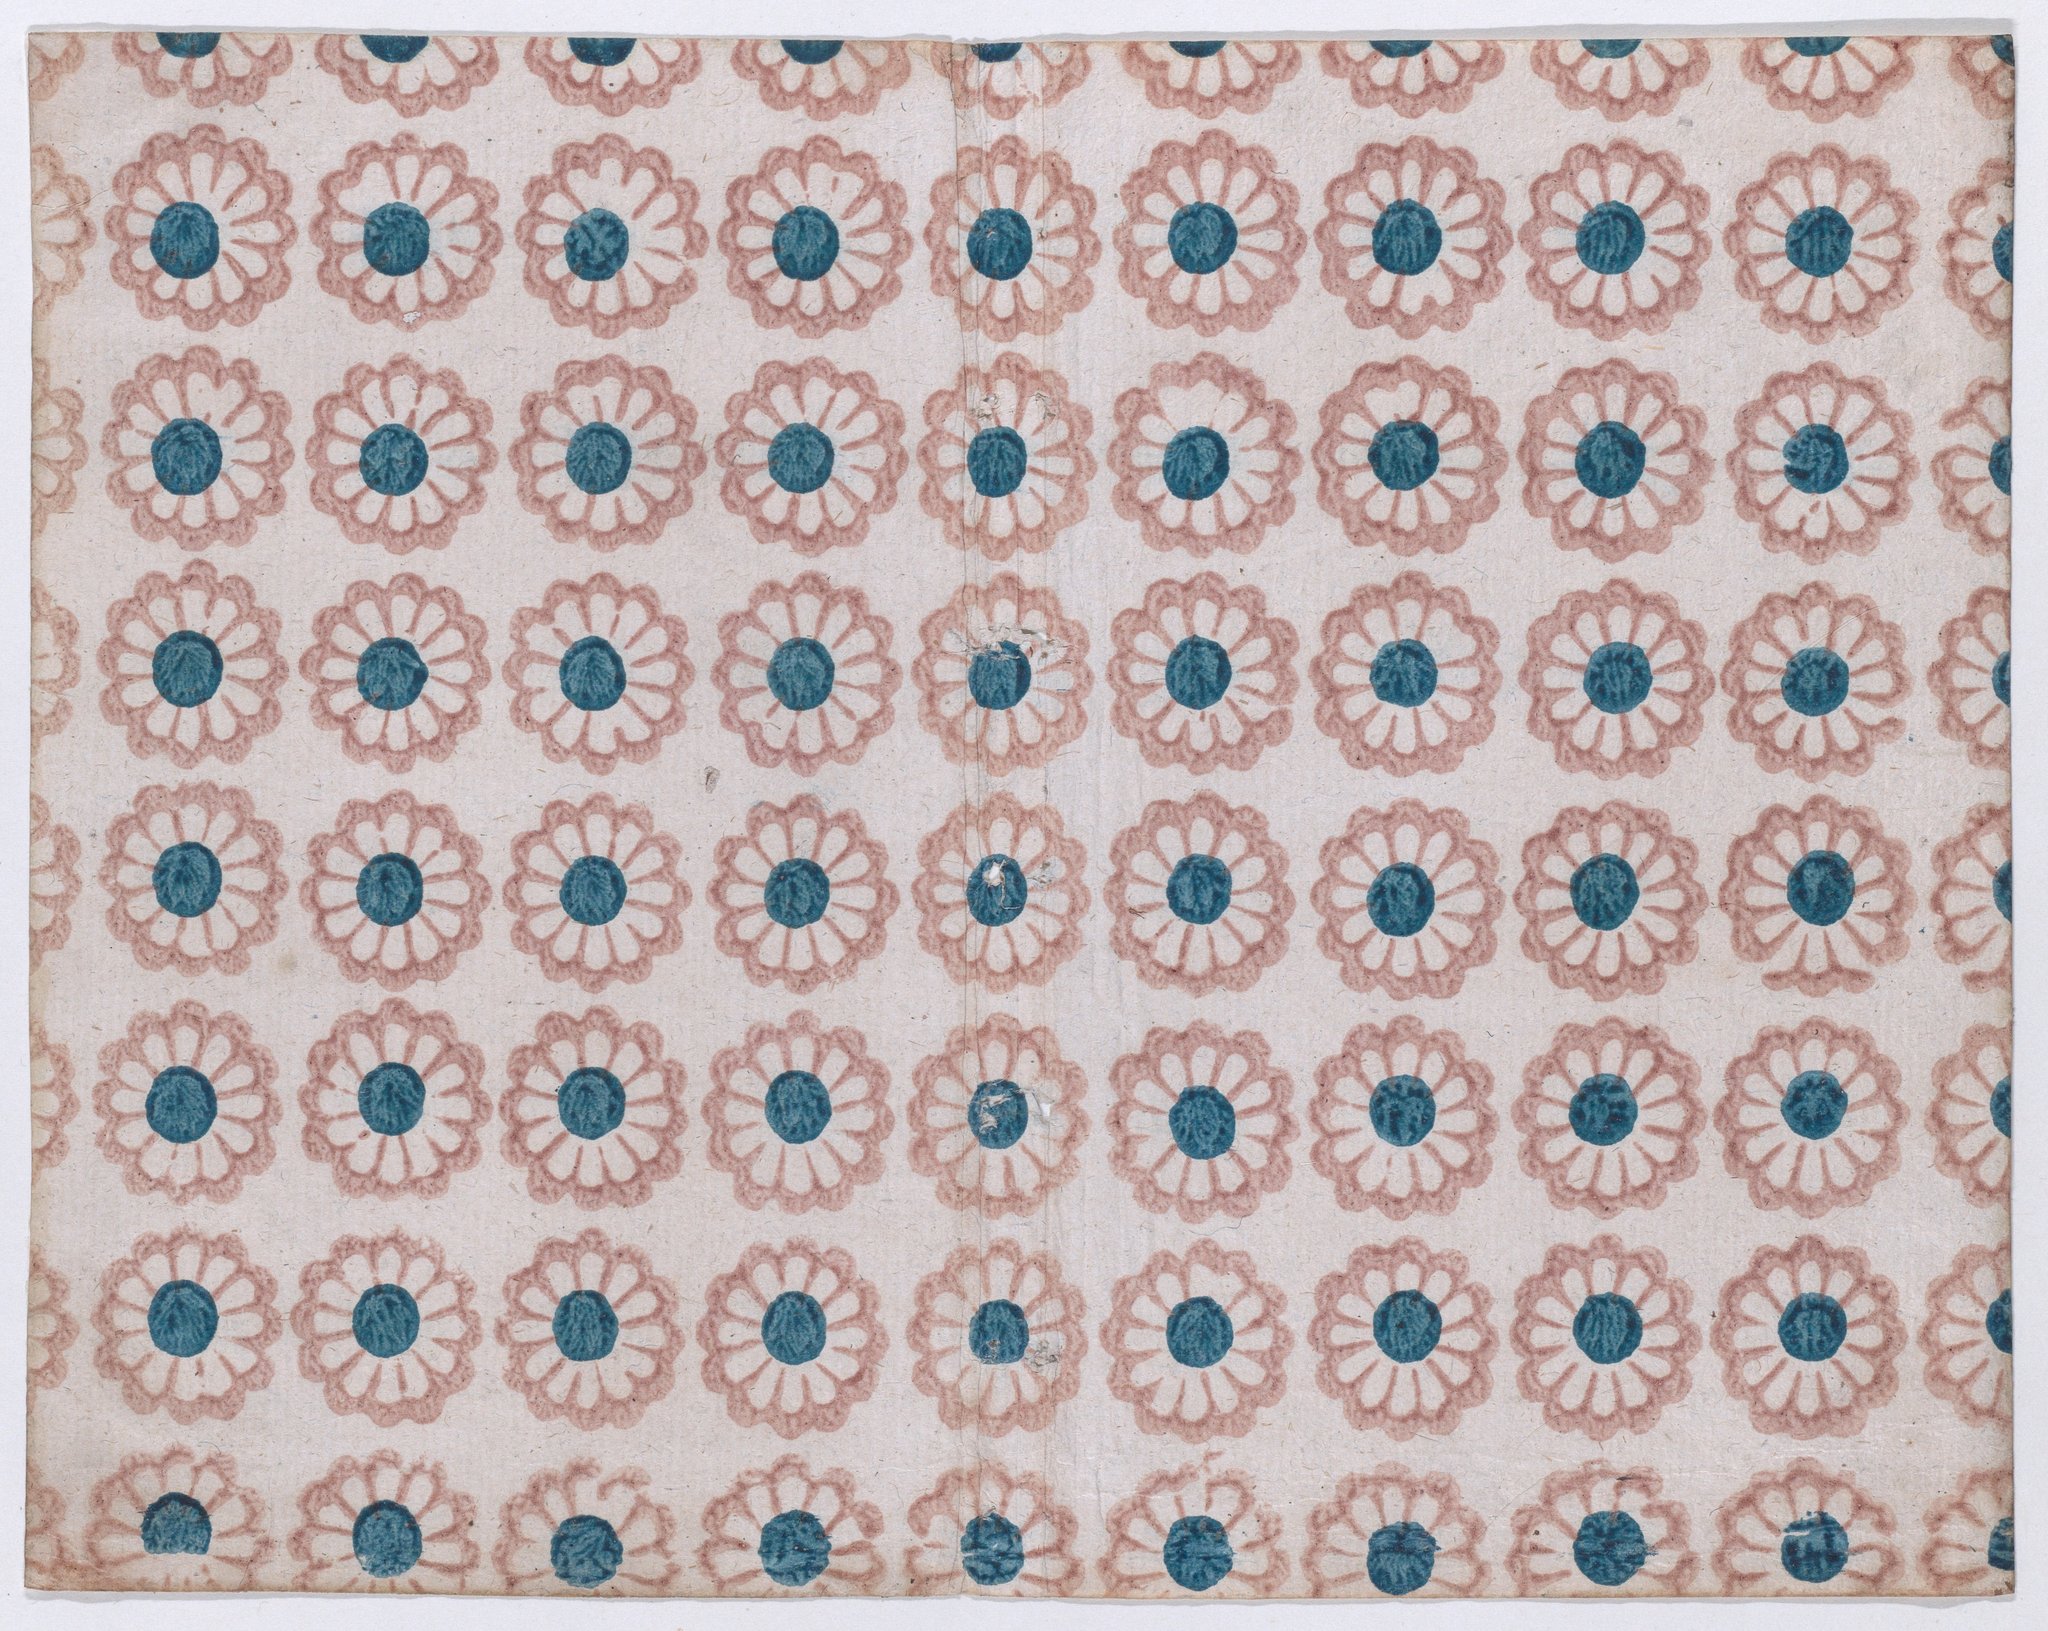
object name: print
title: Sheet with overall pattern of pink flowers with blue centers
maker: Anonymous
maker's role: artist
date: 1801-1900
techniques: relief print